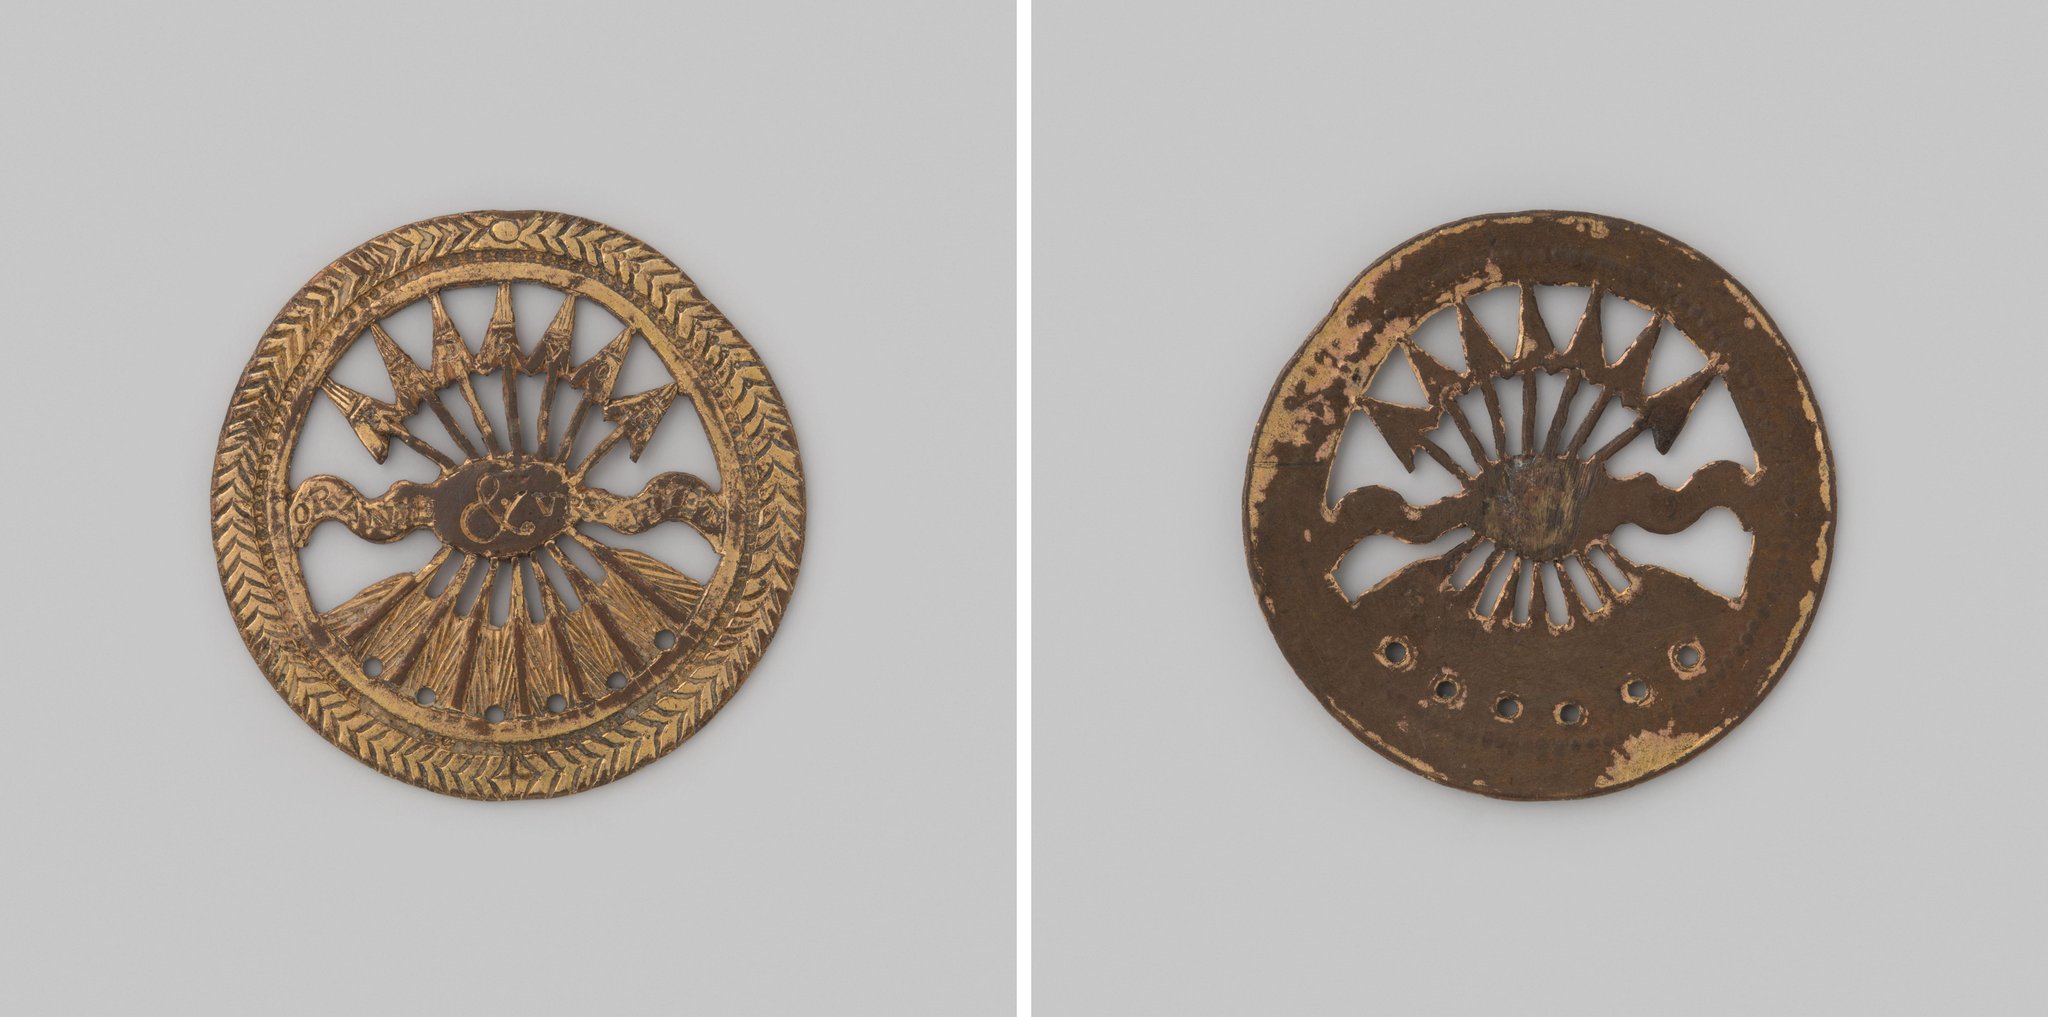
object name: insignia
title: Draagteken patriotten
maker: Anonymous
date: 1750-1799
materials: metal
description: Metalen draagteken in ronde vorm, opengewerkt.